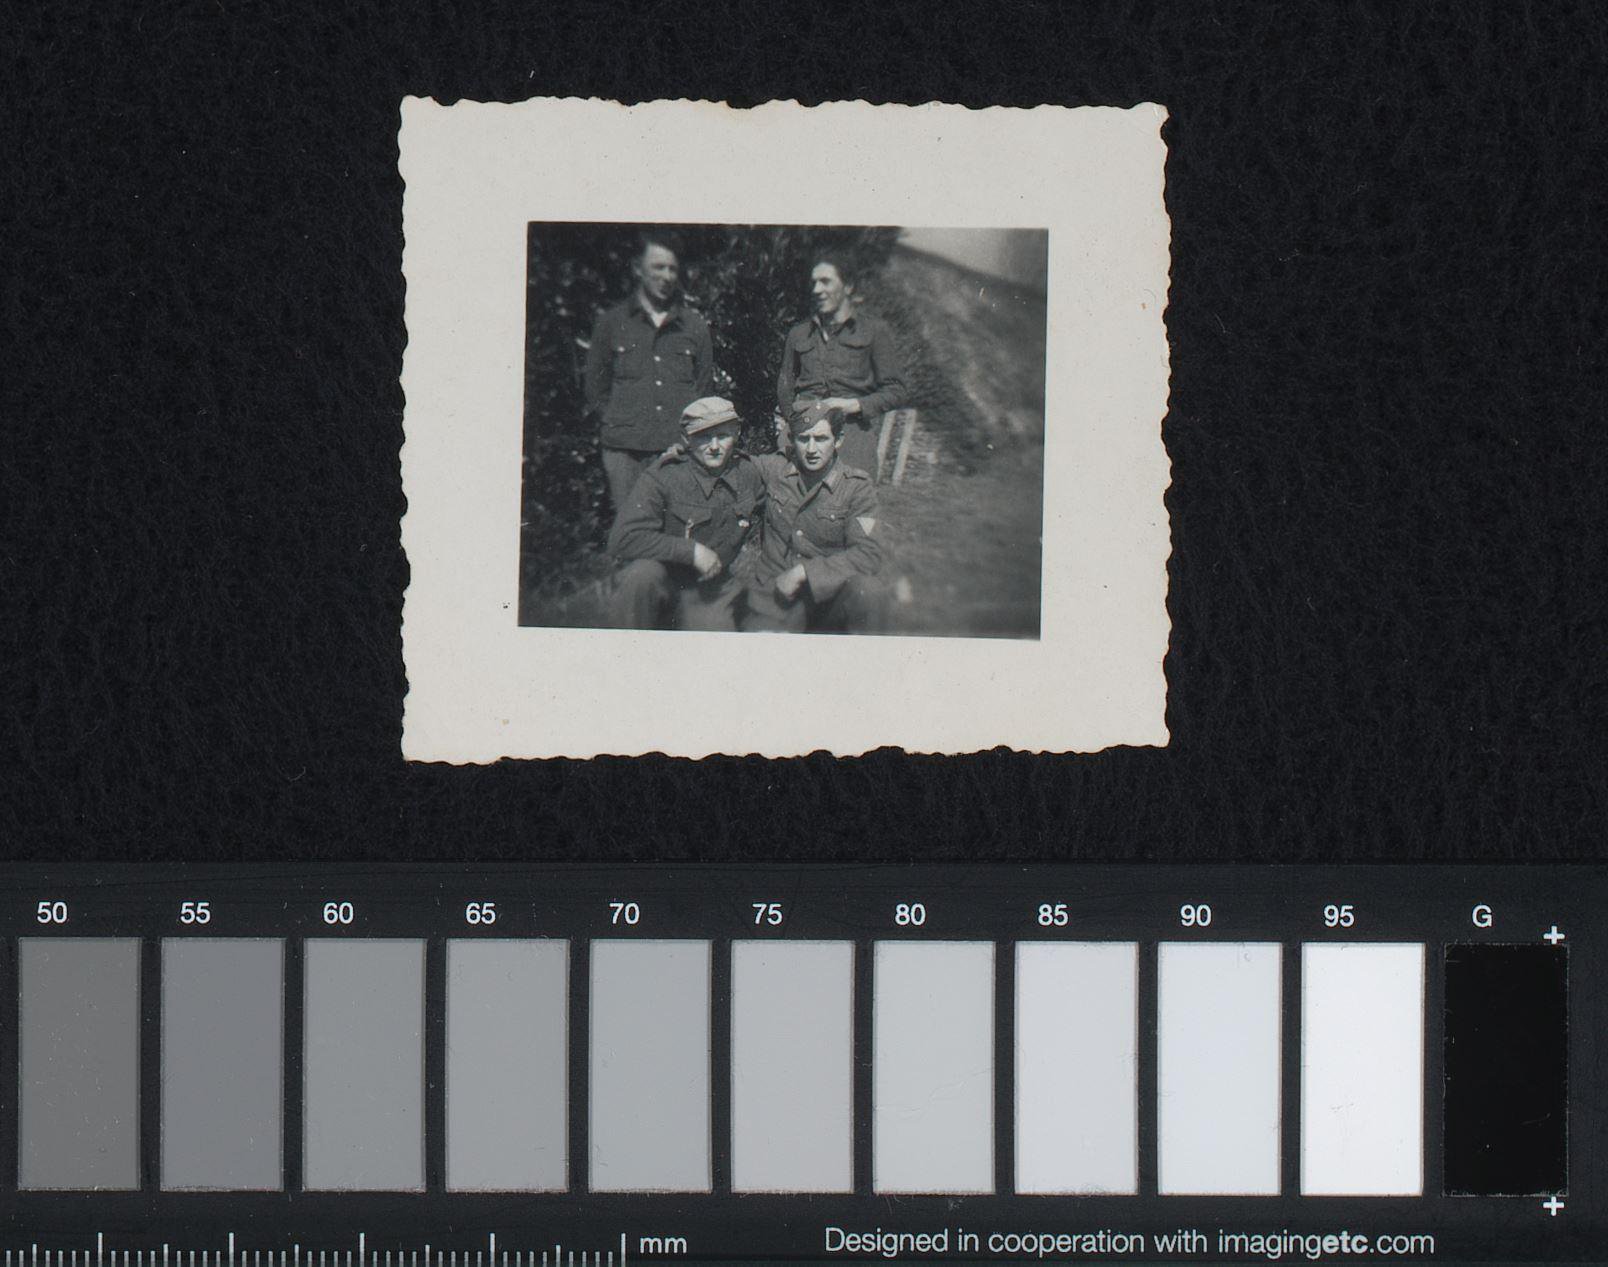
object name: photograph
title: Vier matrozen in een tuin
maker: Anonymous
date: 1940-1943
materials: photographic support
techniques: gelatin silver print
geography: germany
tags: the company, the unit, the troop ~ military service, sailor, germany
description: Vier Duitse matrozen van de Kriegsmarine poseren in een tuin. Onderdeel van de groep losse foto's behorend bij het fotoalbum over de Kriegsmarine 1940-1943.